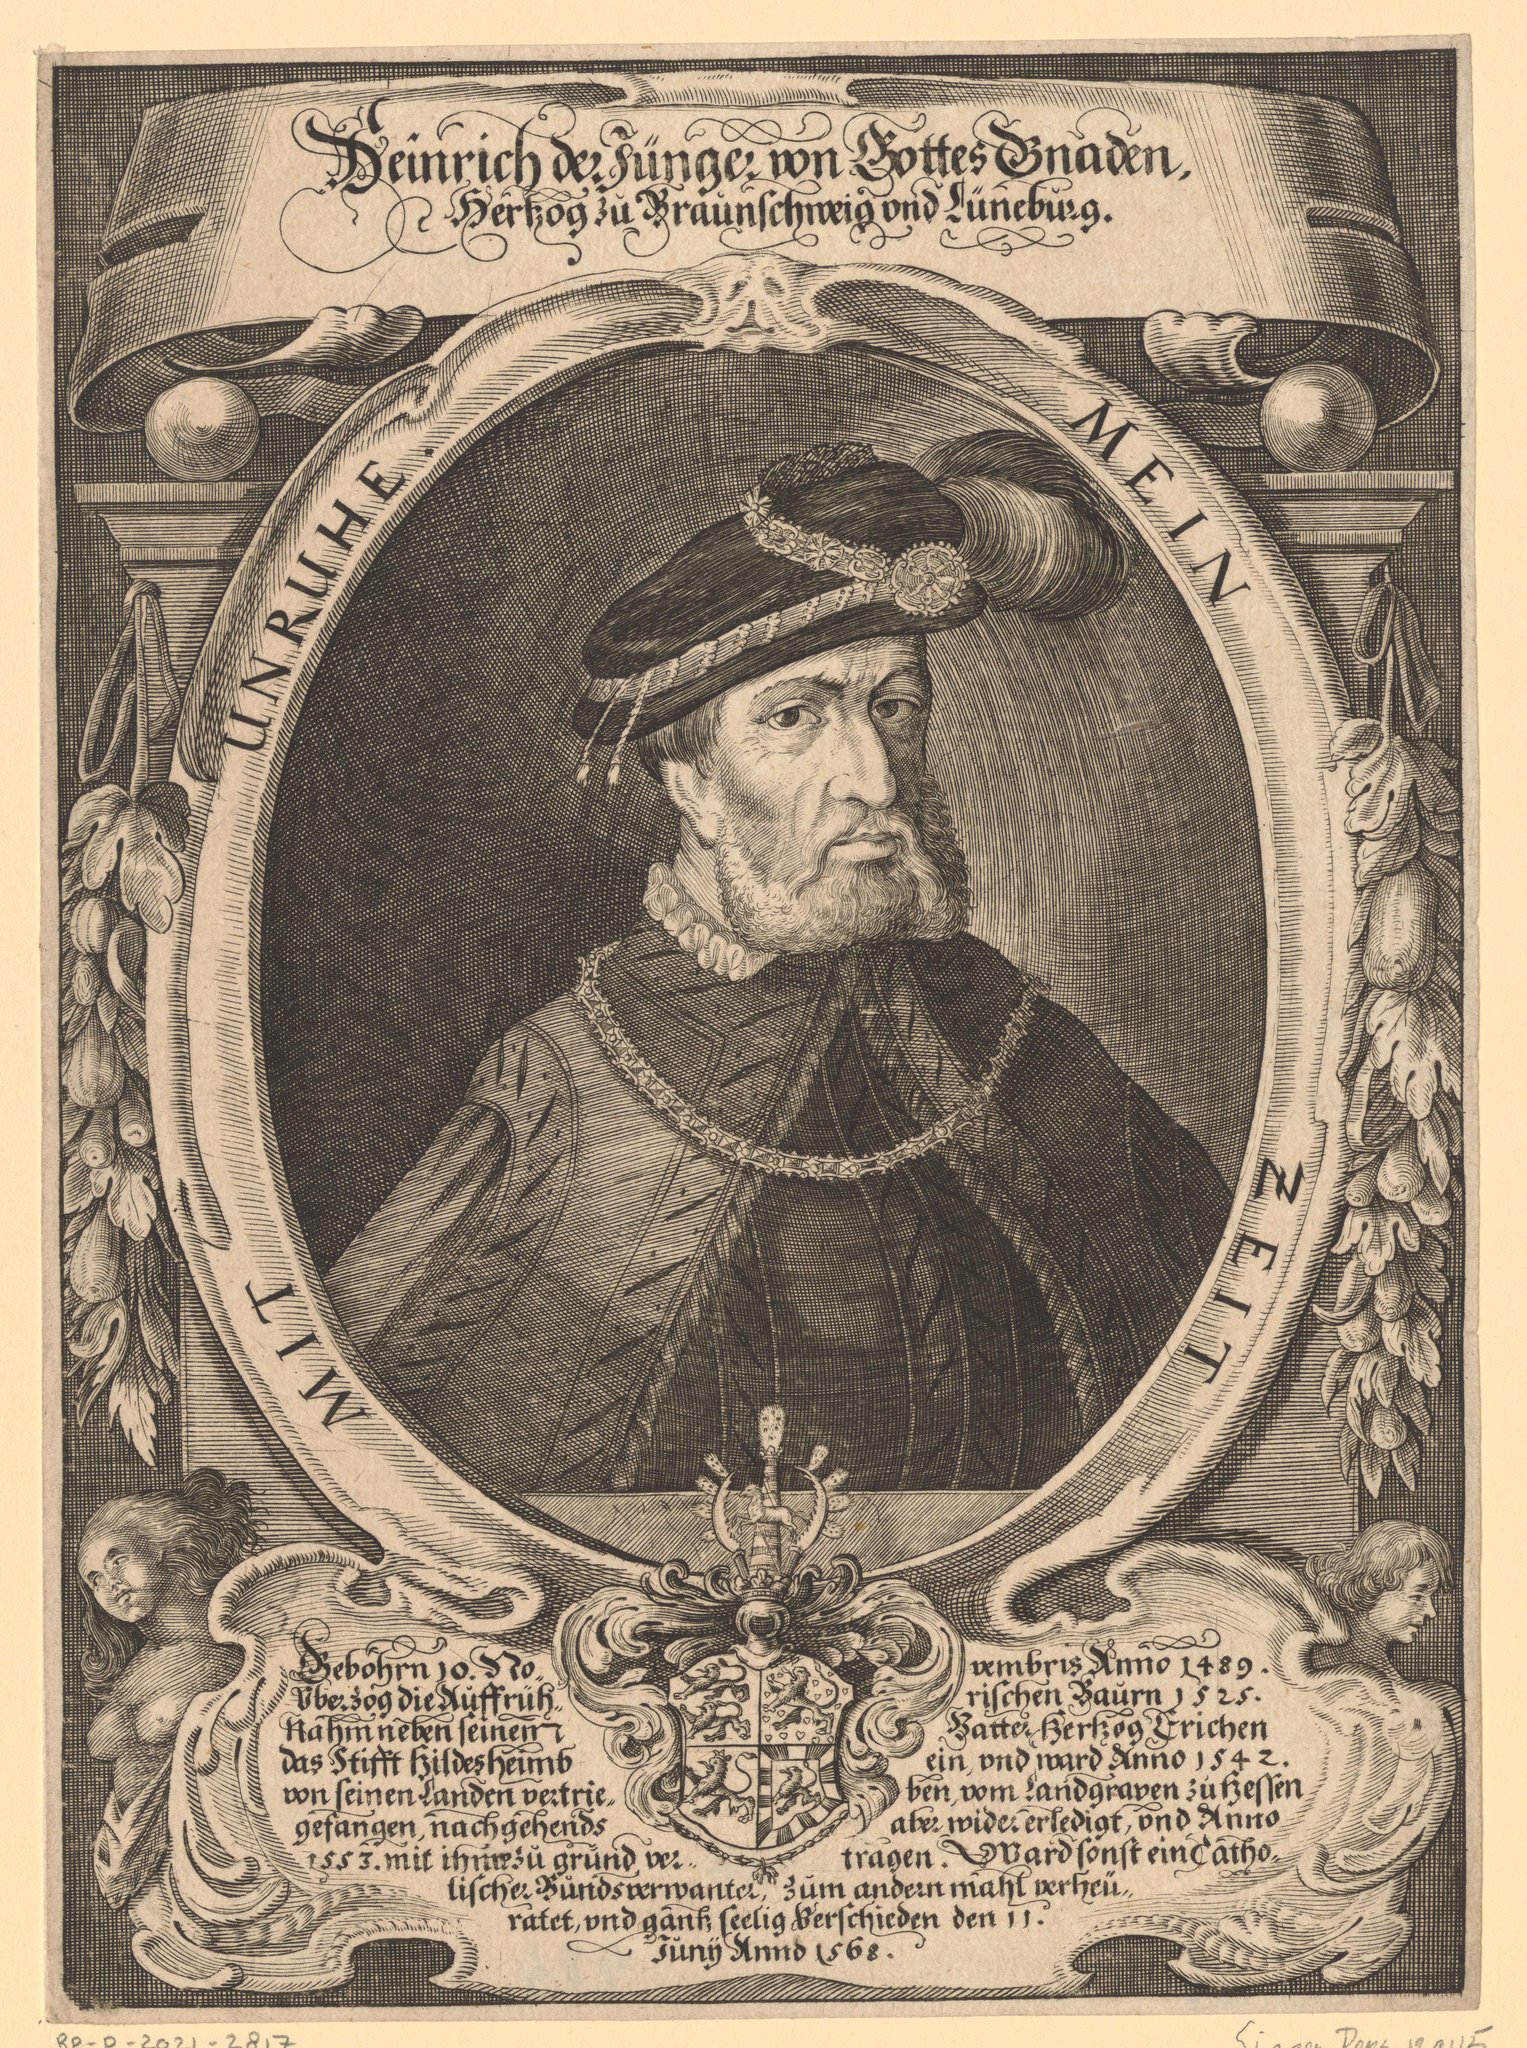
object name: print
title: Portret van Hendrik II, hertog van Brunswijk-Wolfenbüttel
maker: georg walch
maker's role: print maker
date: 1632-1654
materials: paper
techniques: engraving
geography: nuremberg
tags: historical persons, armorial bearing, heraldry